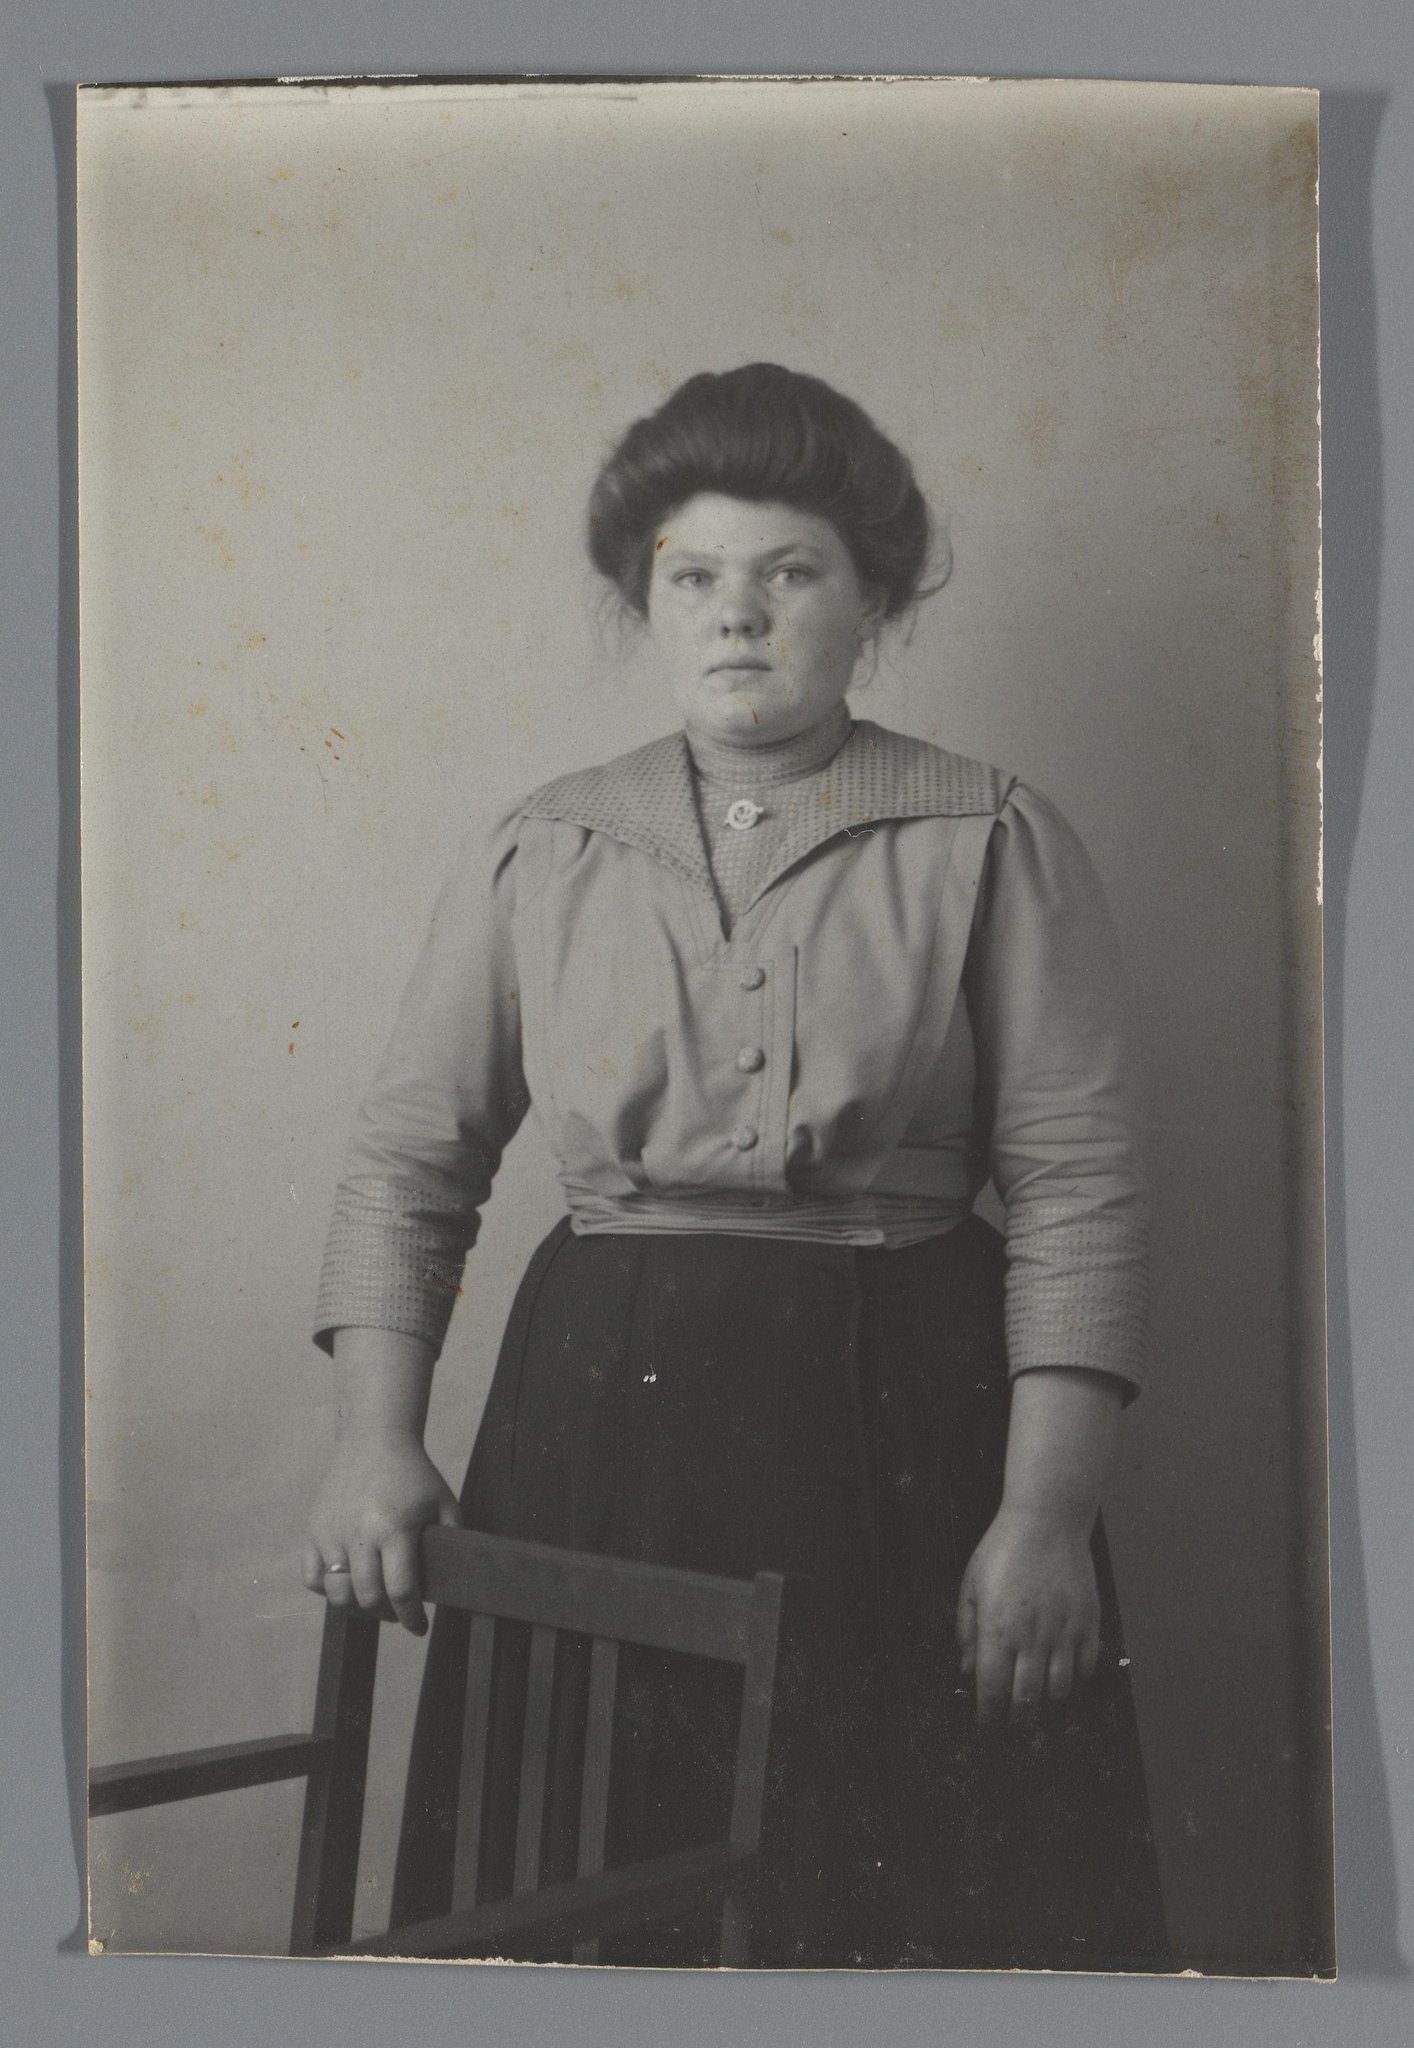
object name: snapshot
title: Portret van een vrouw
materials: photographic support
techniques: gelatin silver print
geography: groningen